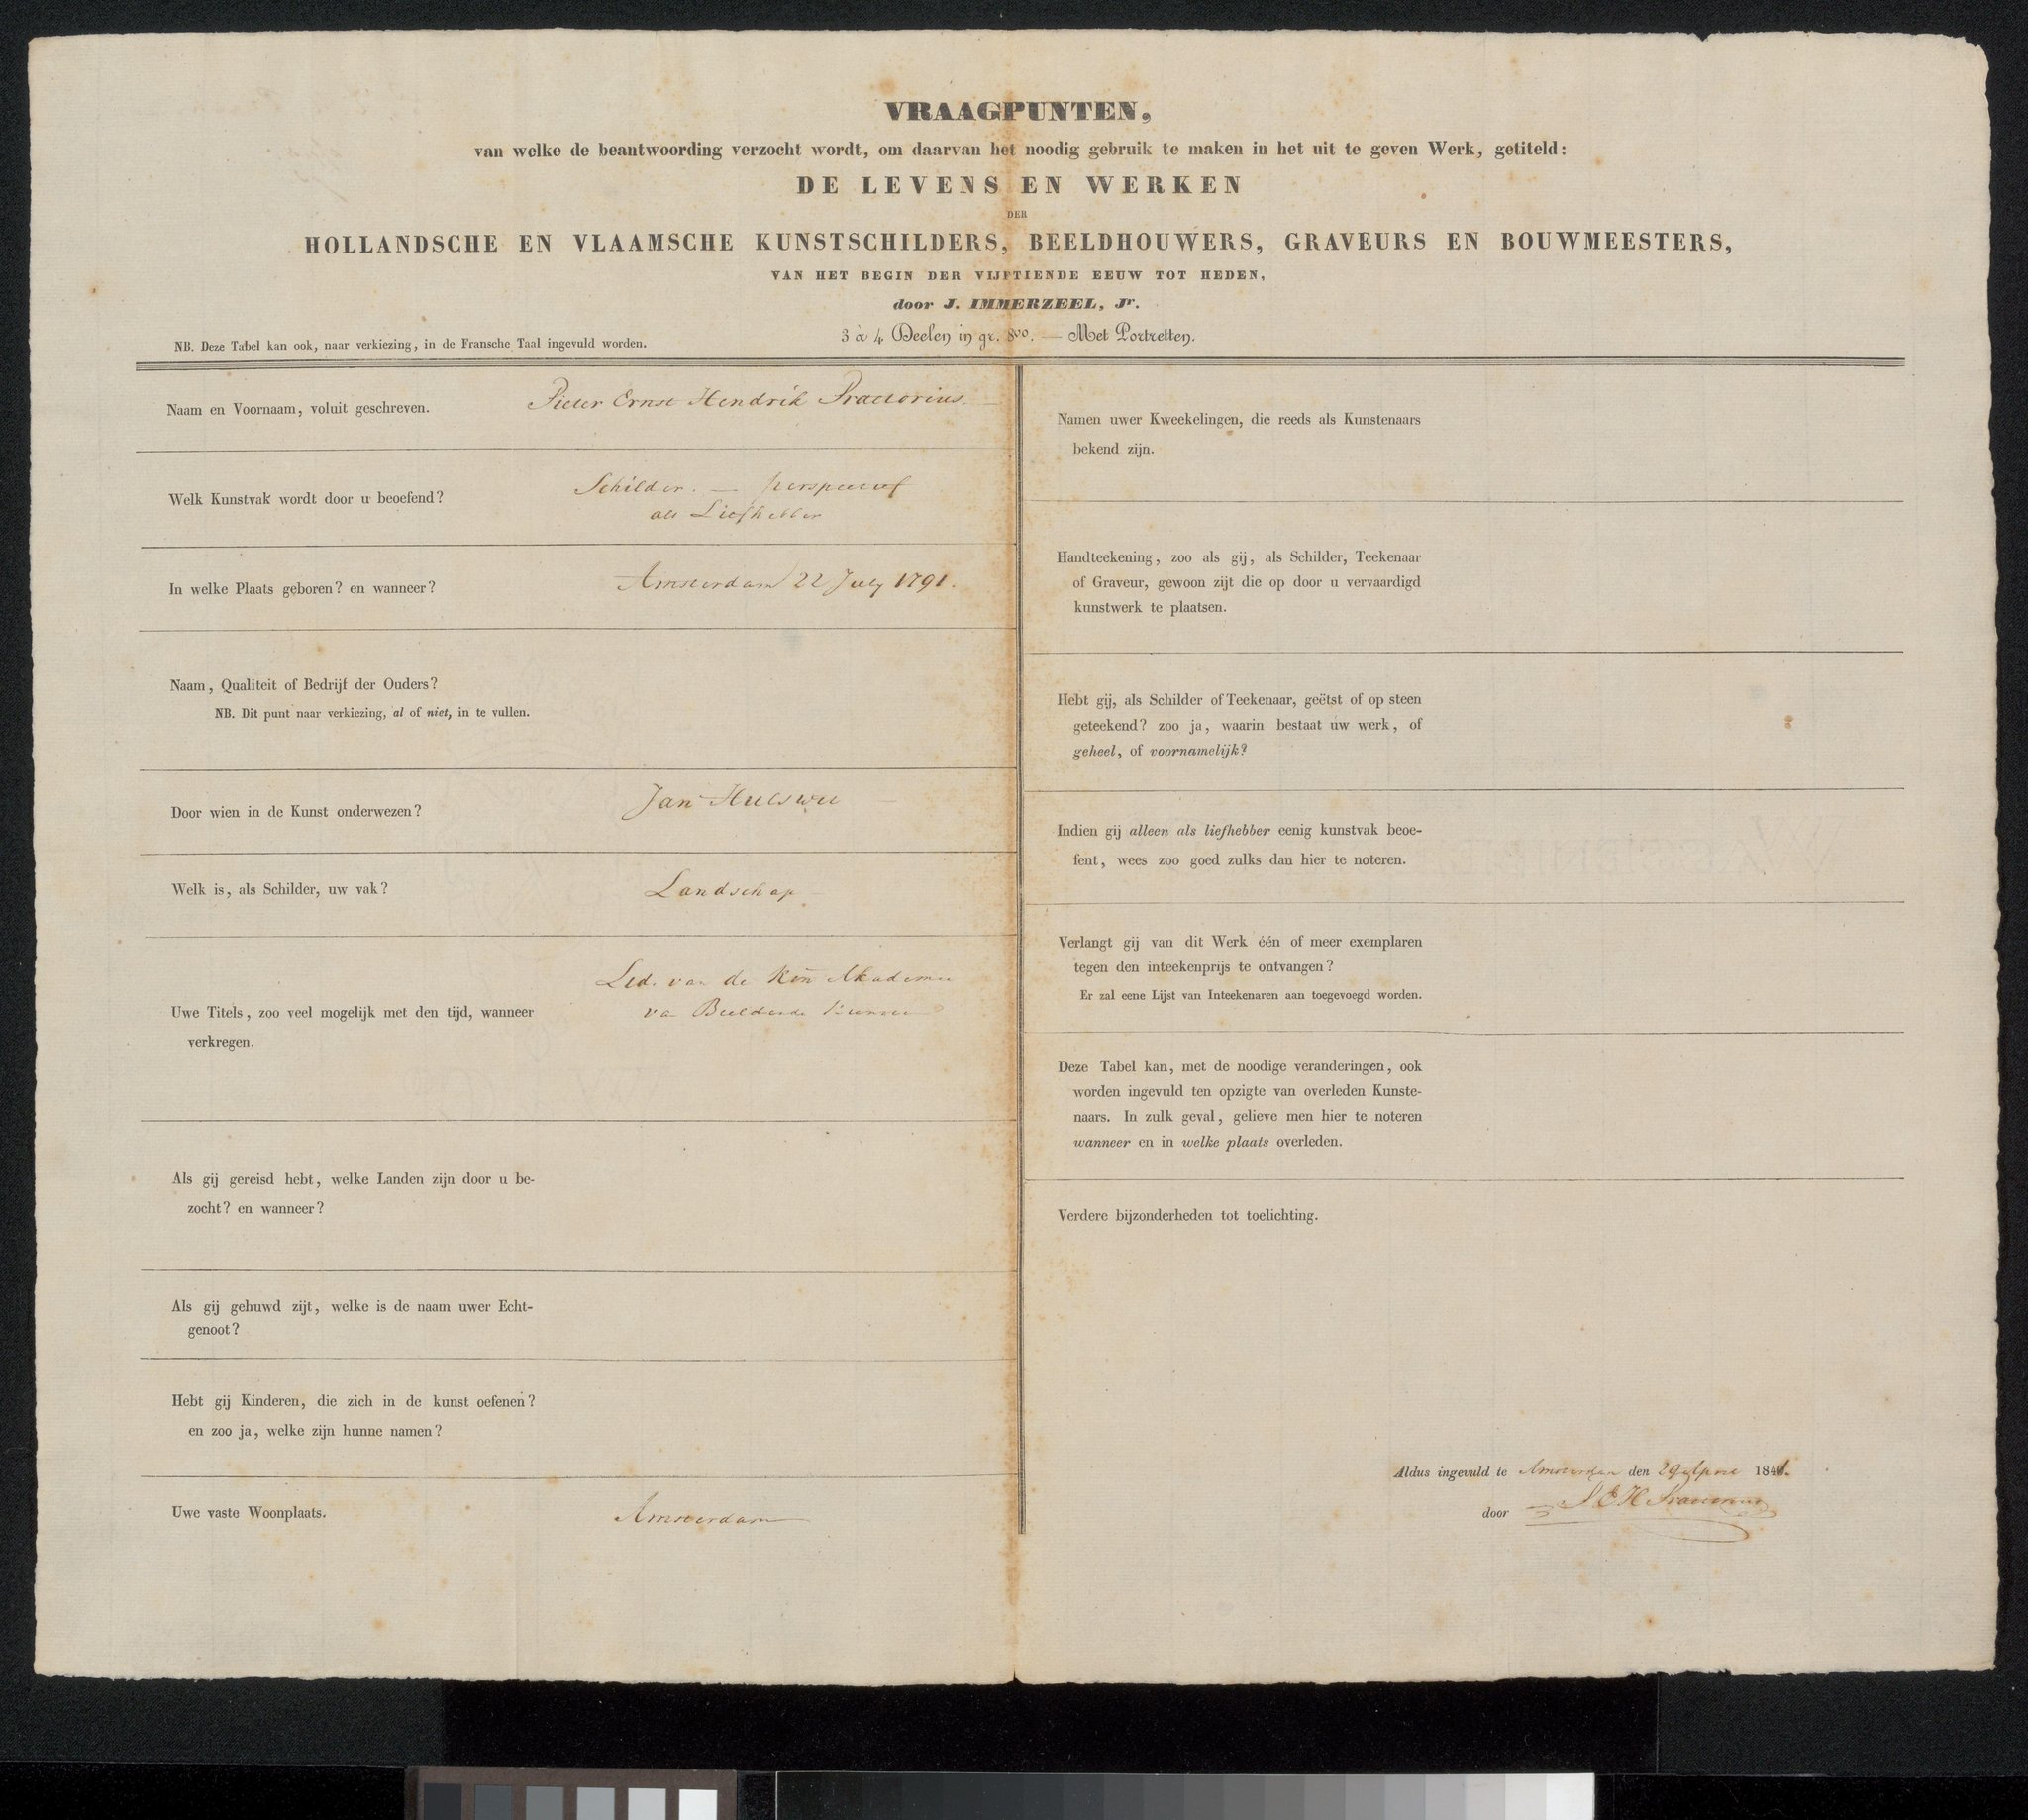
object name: manuscript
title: Enquêteformulier ingevuld door Pieter Ernst Hendrik Praetorius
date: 1841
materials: ink, paper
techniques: pen, printing, writing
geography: amsterdam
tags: amsterdam, pieter ernst hendrik praetorius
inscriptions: inscription: ‘Vraagpunten,/ van welke de beantwoording verzocht wordt, om daarvan het noodig gebruik te maken in het uit te geven Werk, getiteld: De levens en werken/ der Hollandsche en Vlaamsche kunstschilders, beeldhouwers,/ graveurs en bouwmeesters, van het begin der vijftiende eeuw tot heden/ door J. Immerzeel, Jr.’, watermark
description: Opgenomen in: Immerzeel, J. Jr., De levens en werken der Hollandsche en Vlaamsche kunstschilders, beeldhouwers, graveurs en bouwmeesters, van het begin der vijftiende eeuw tot heden, Amsterdam: J.C. van Kesteren, 1842-1843.